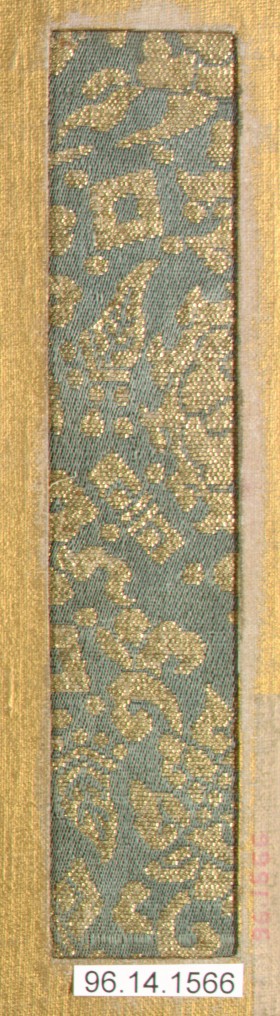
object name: piece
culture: japanese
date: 1701-1900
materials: silk